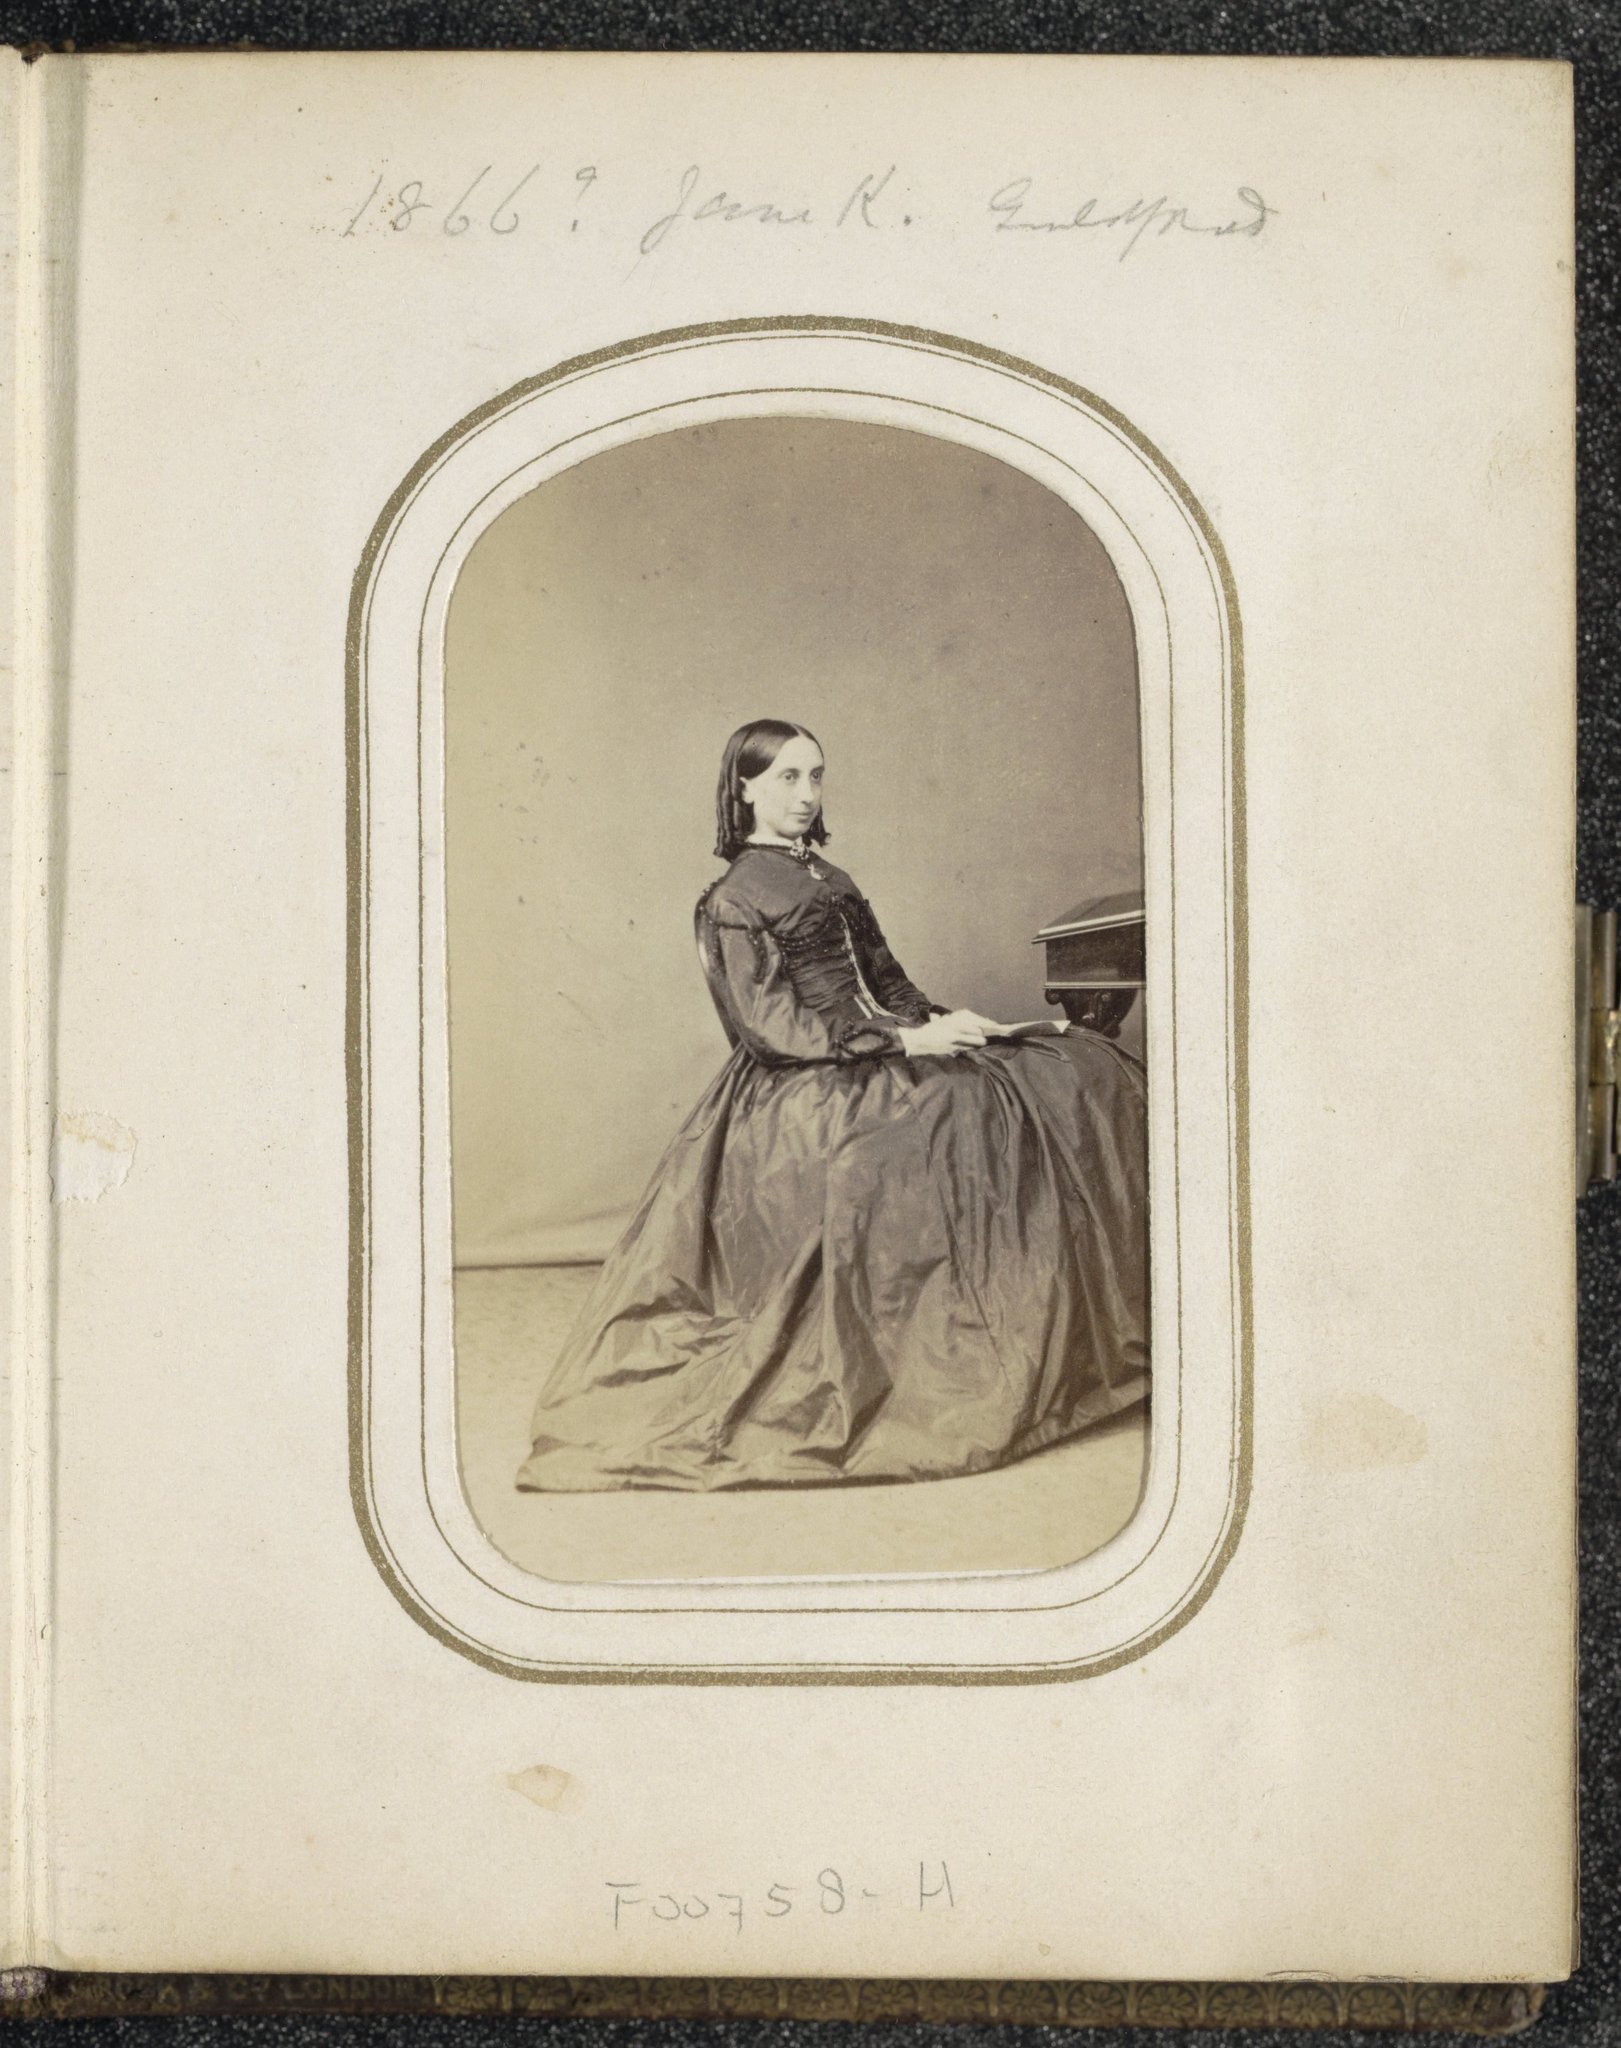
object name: carte de visite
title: Portret van een vrouw met een boek zittend bij een lessenaar, aangeduid als Jane K.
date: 1866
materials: cardboard, paper, photographic support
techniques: albumen print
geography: guildford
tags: studio requisites ~ photographer, historical persons, dress, gown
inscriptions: address: ‘Guildford, 32 High St.’, inscription: ‘1866? Jane K. [...]’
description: Onderdeel van Engels fotoalbum van E.A. Kettle met 42 cartes-de-visite.